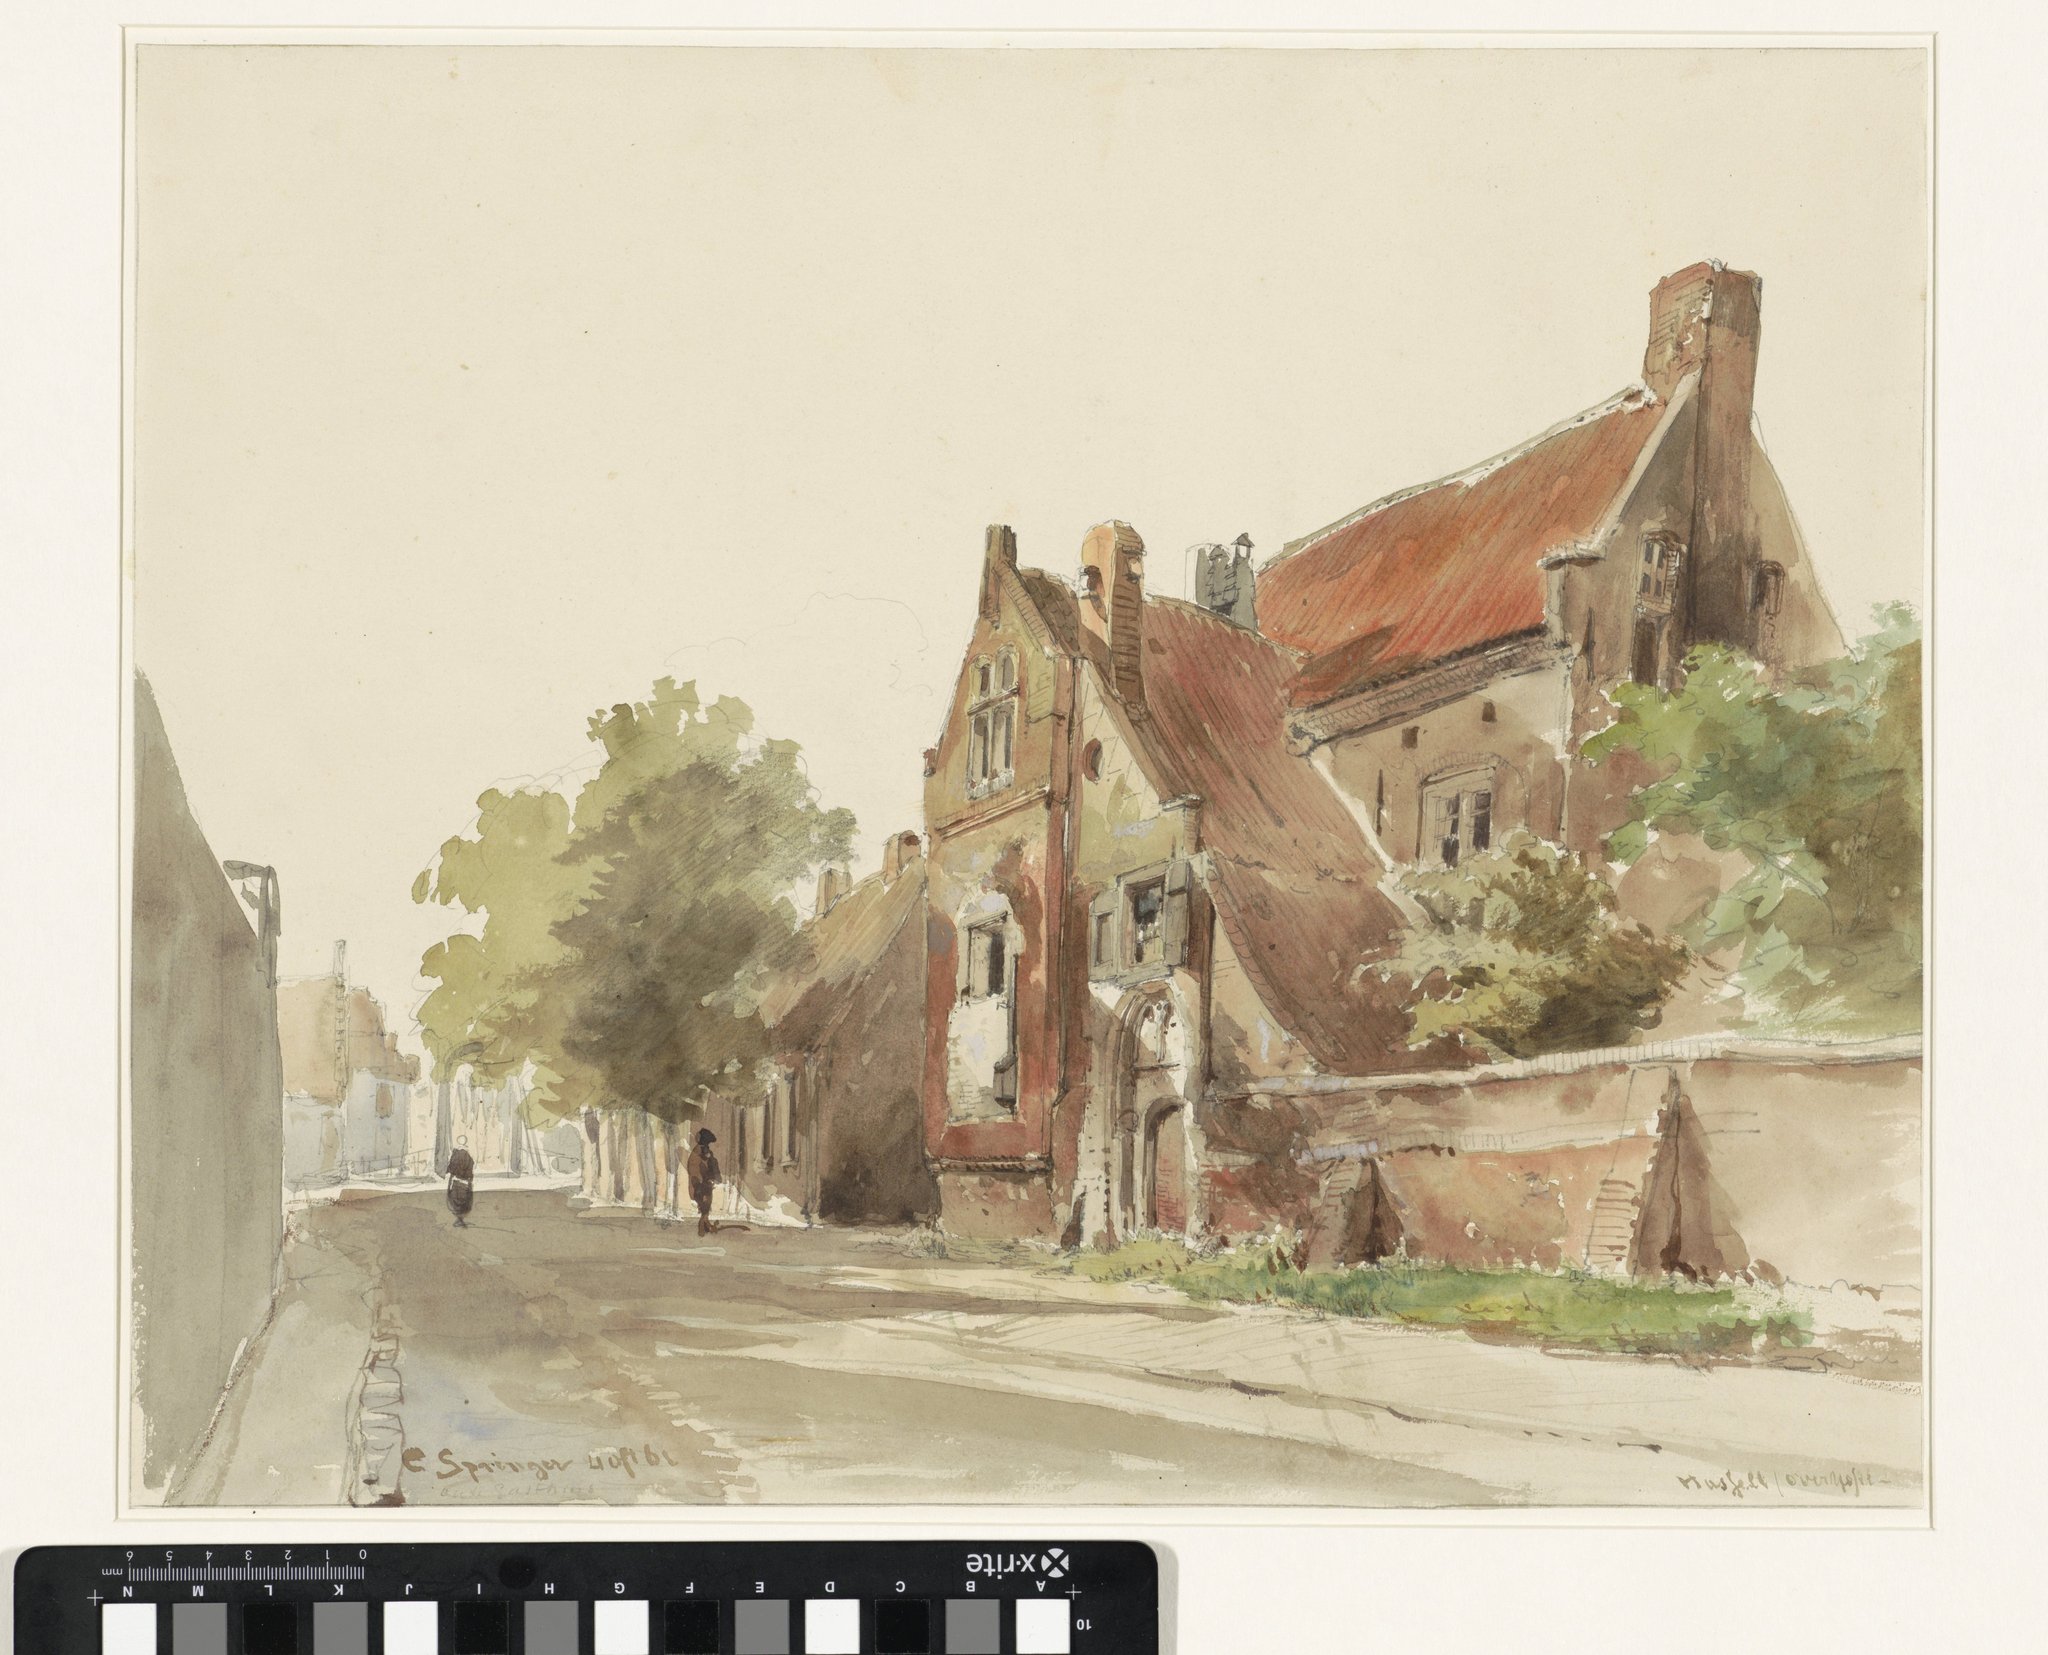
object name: drawing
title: Het oude gasthuis te Hasselt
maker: cornelis springer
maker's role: draughtsman, painter, print maker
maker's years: 1817-1891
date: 1861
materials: paper, pencil, watercolor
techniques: brush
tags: public road